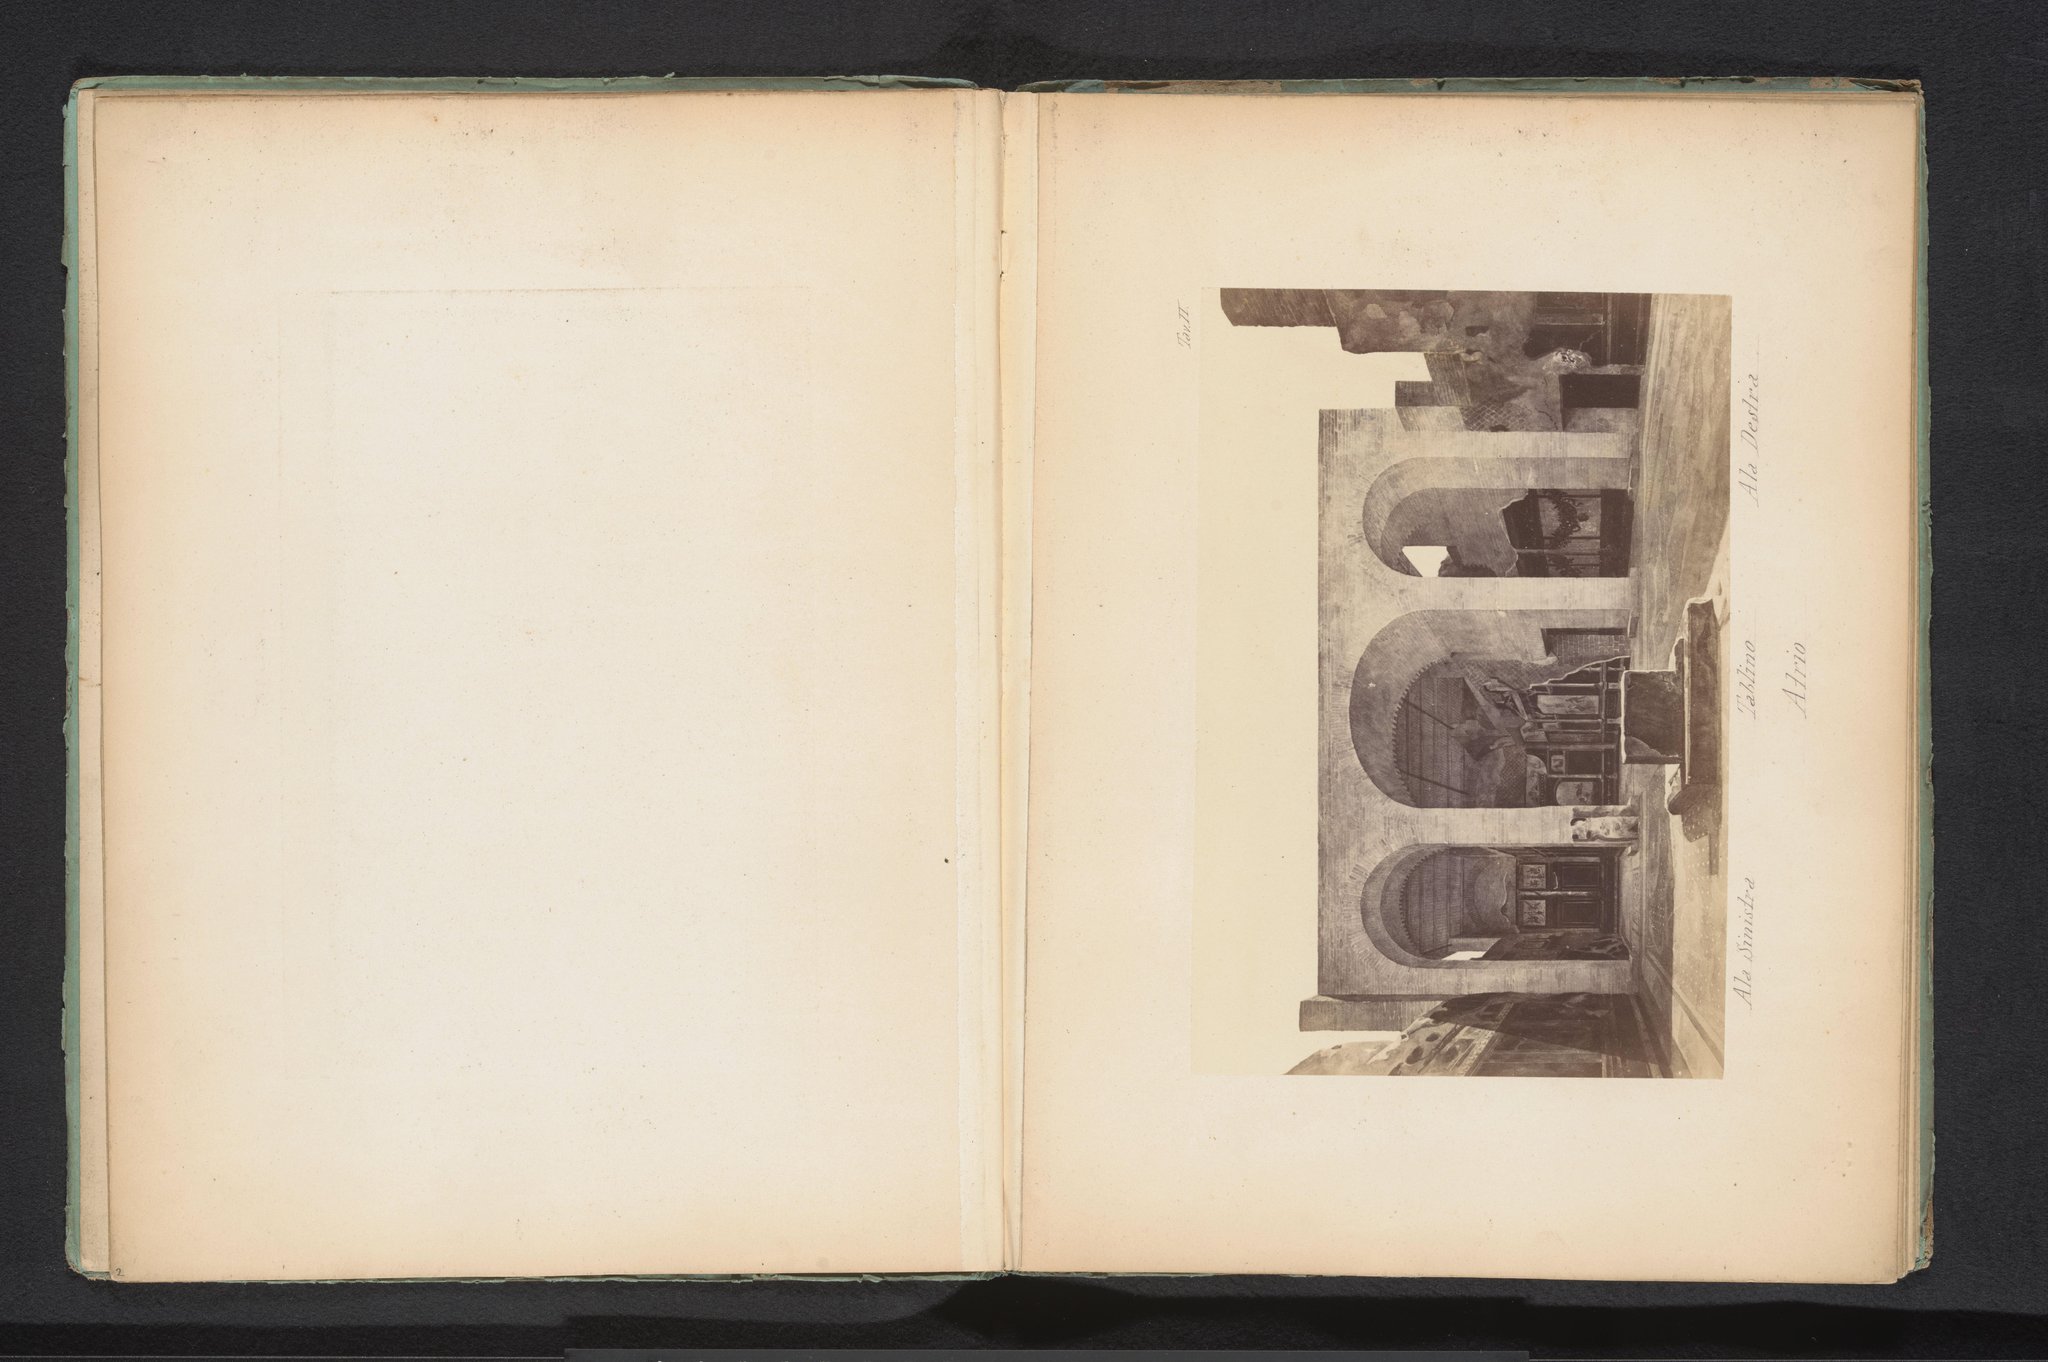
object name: reproduction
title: Tablino Atrio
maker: Anonymous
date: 1859-1869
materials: photographic support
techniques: albumen print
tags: vestibule, hall, ruin of a dwelling, house, castle, etc., rome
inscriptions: number: ‘Tav. II.’, inscription: ‘Ala Sinistra Ala Destra’